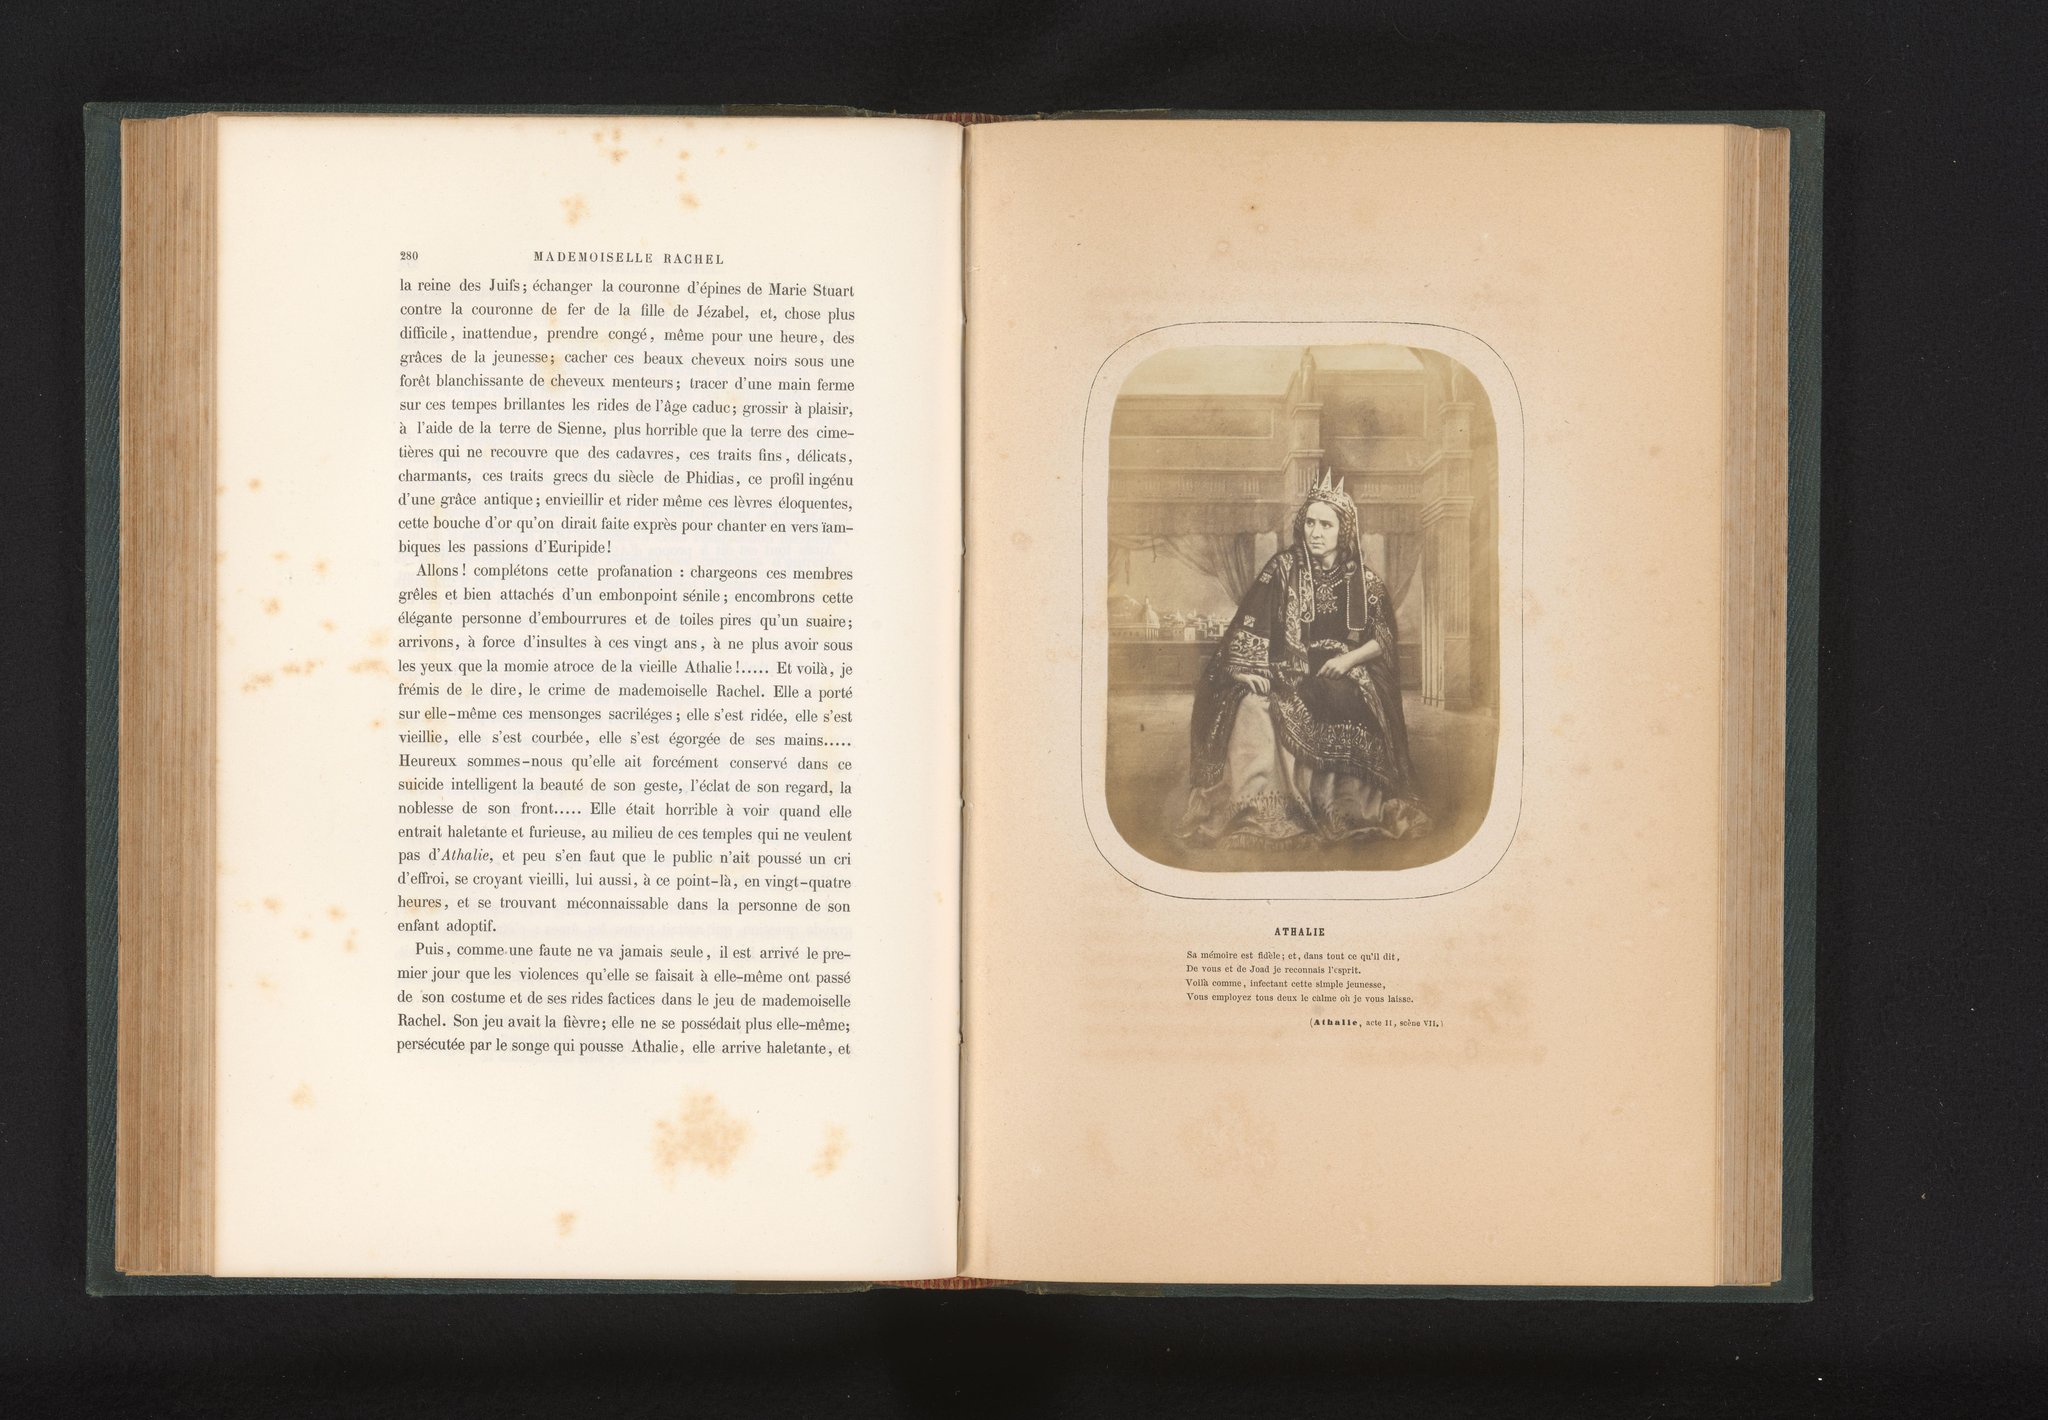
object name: reproduction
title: Athalie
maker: henri de la blanchère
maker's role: fotograaf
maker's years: 1821-1880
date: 1854-1859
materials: paper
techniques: albumen print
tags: portrait of actor, actress, picture, painting